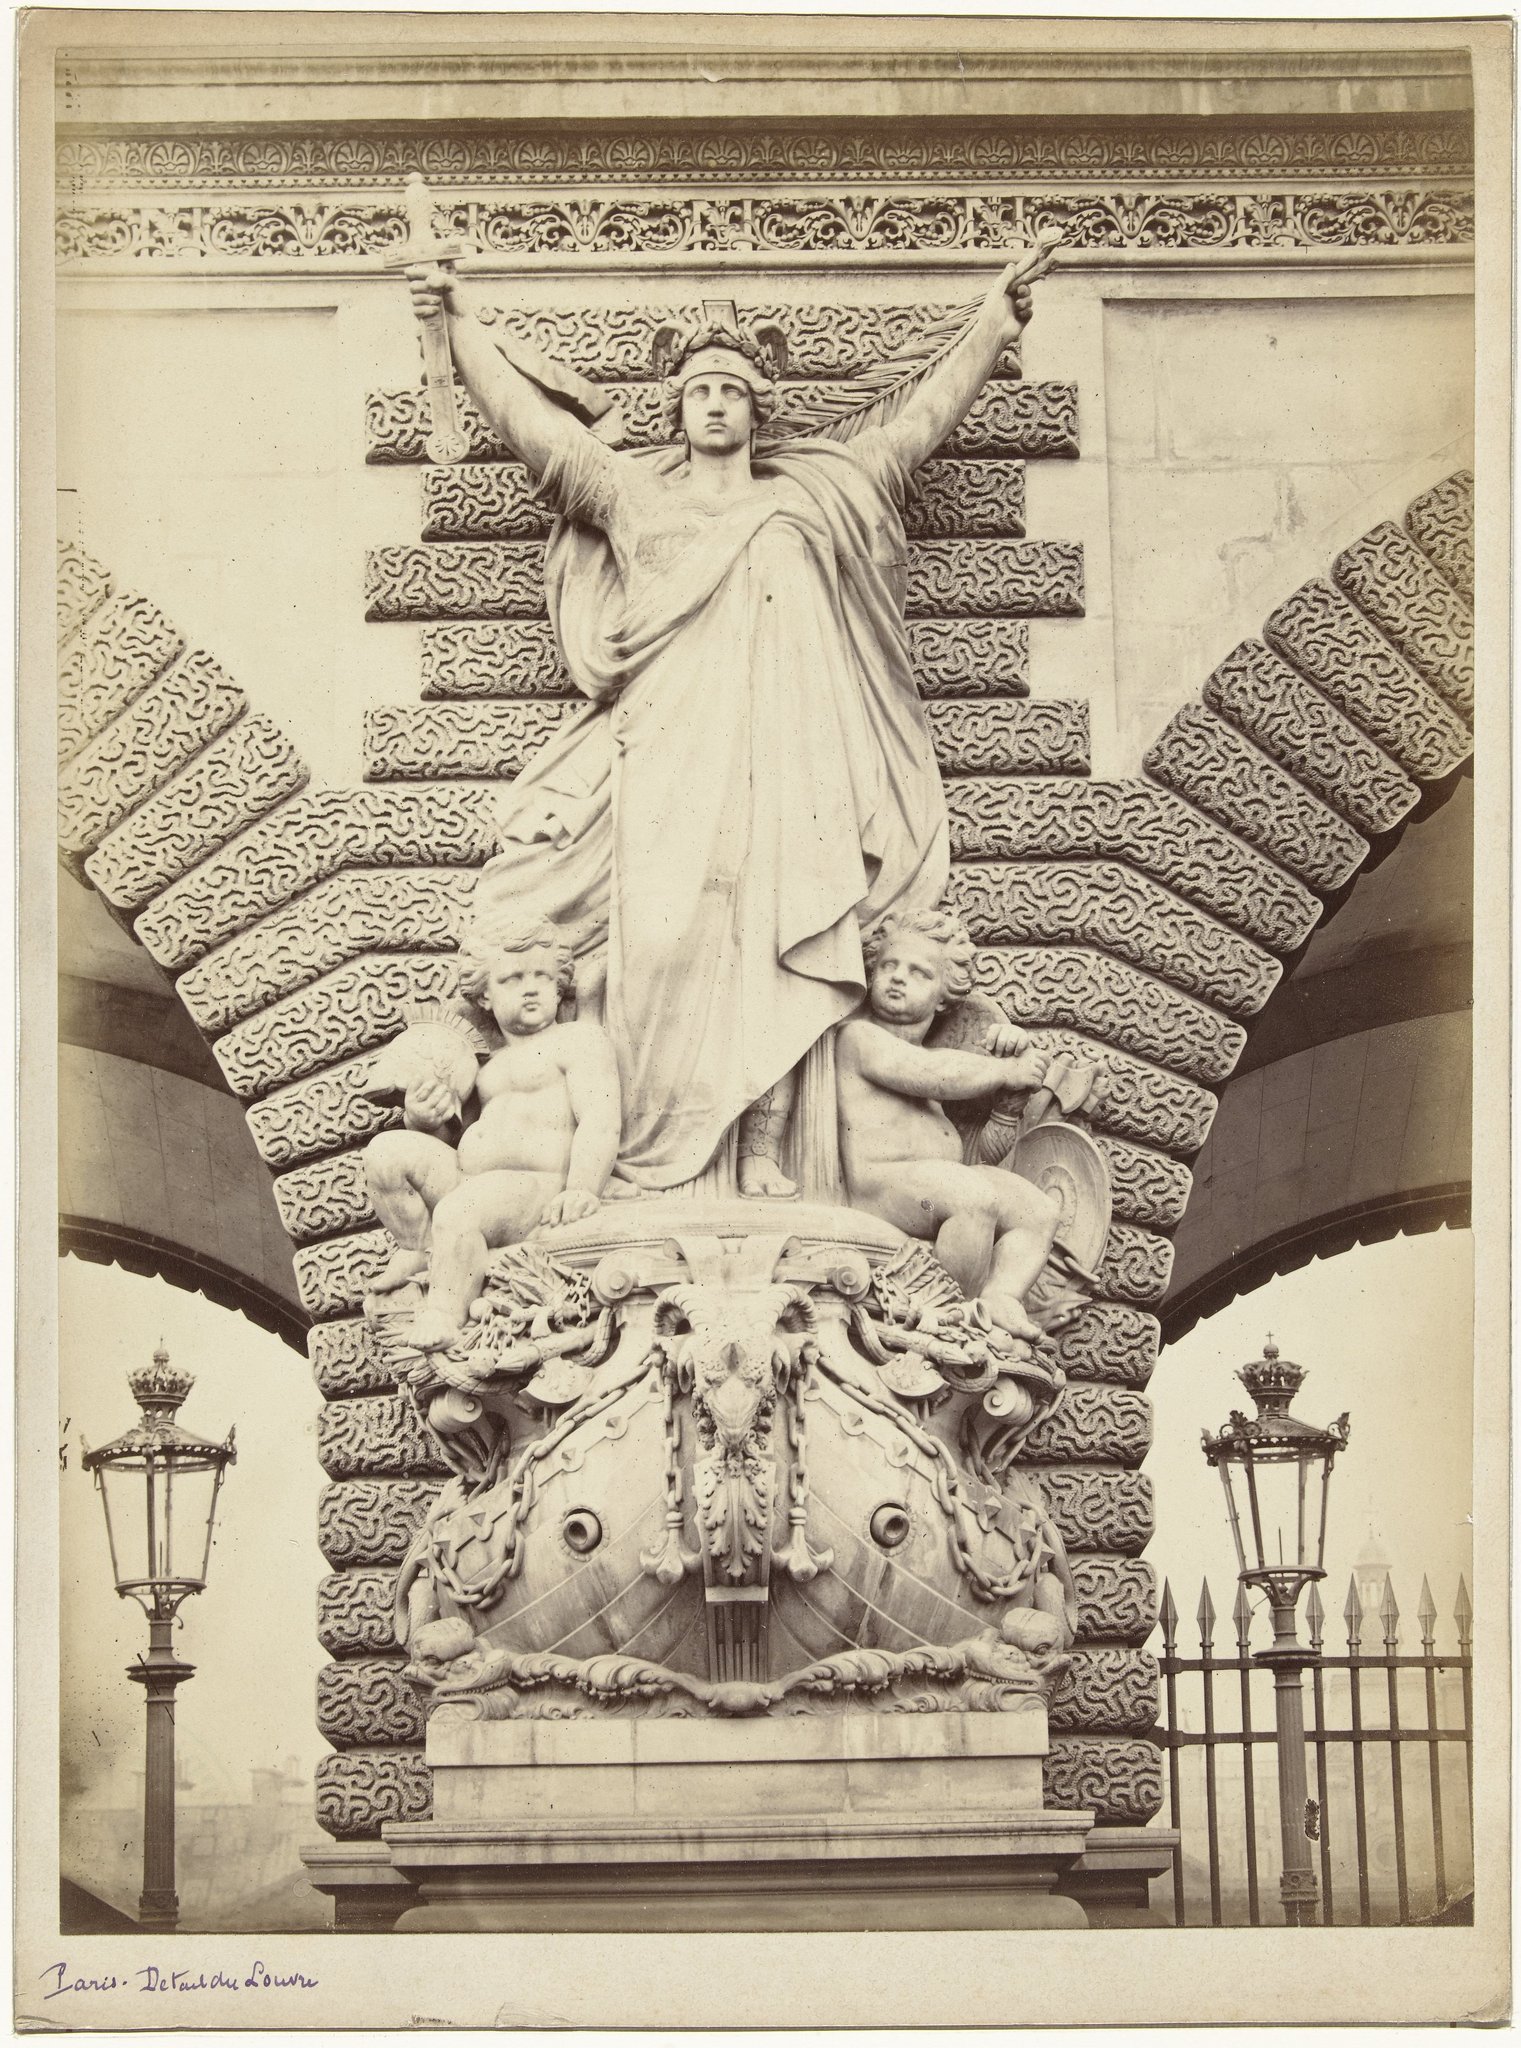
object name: photograph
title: Sculptuur aan de gevel van het Louvre in Parijs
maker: Anonymous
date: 1860-1890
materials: cardboard, paper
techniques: albumen print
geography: paris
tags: sculpture